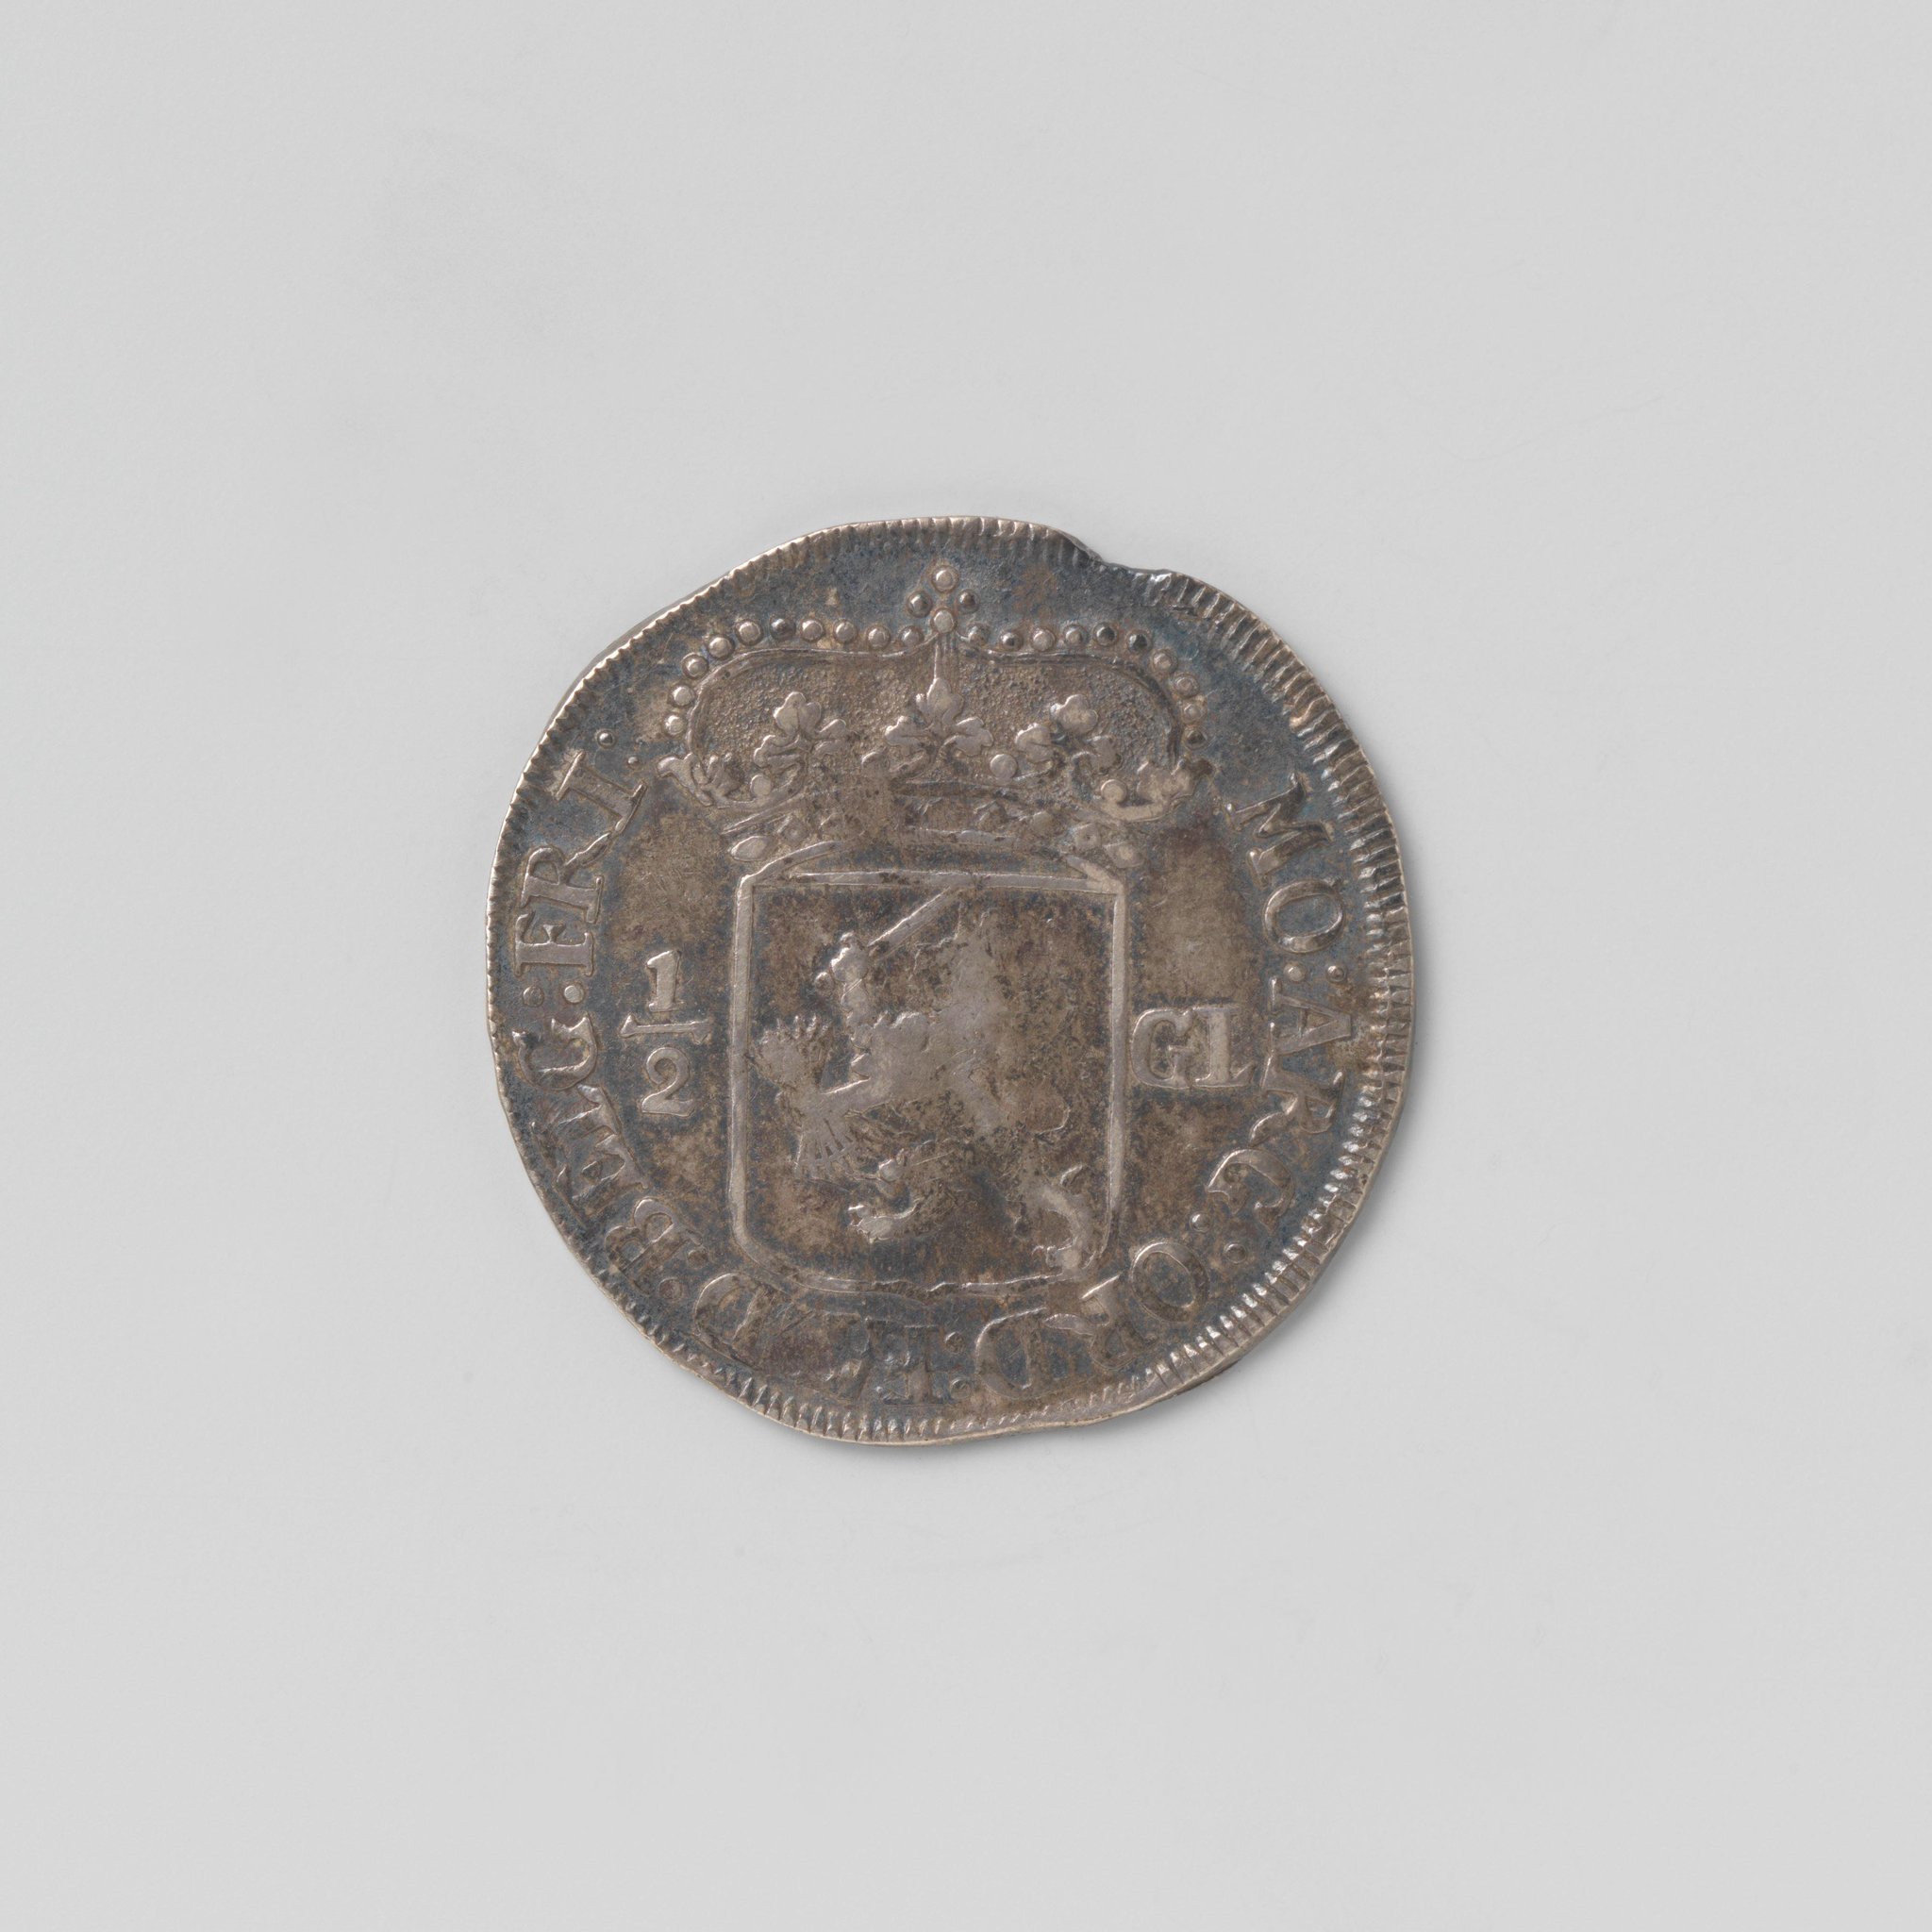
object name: halve gulden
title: Halve gulden van Friesland, 1696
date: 1696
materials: silver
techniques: striking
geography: leeuwarden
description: Zilveren munt. Voorzijde: tussen waarde-aanduiding gekroond generaliteitswapenschild. Keerzijde: staande Nederlandse maagd met in rechterhand speer, waarop hoed, met linkerhand steunend op een altaar, waarop bijbel. In afsnede jaartal.